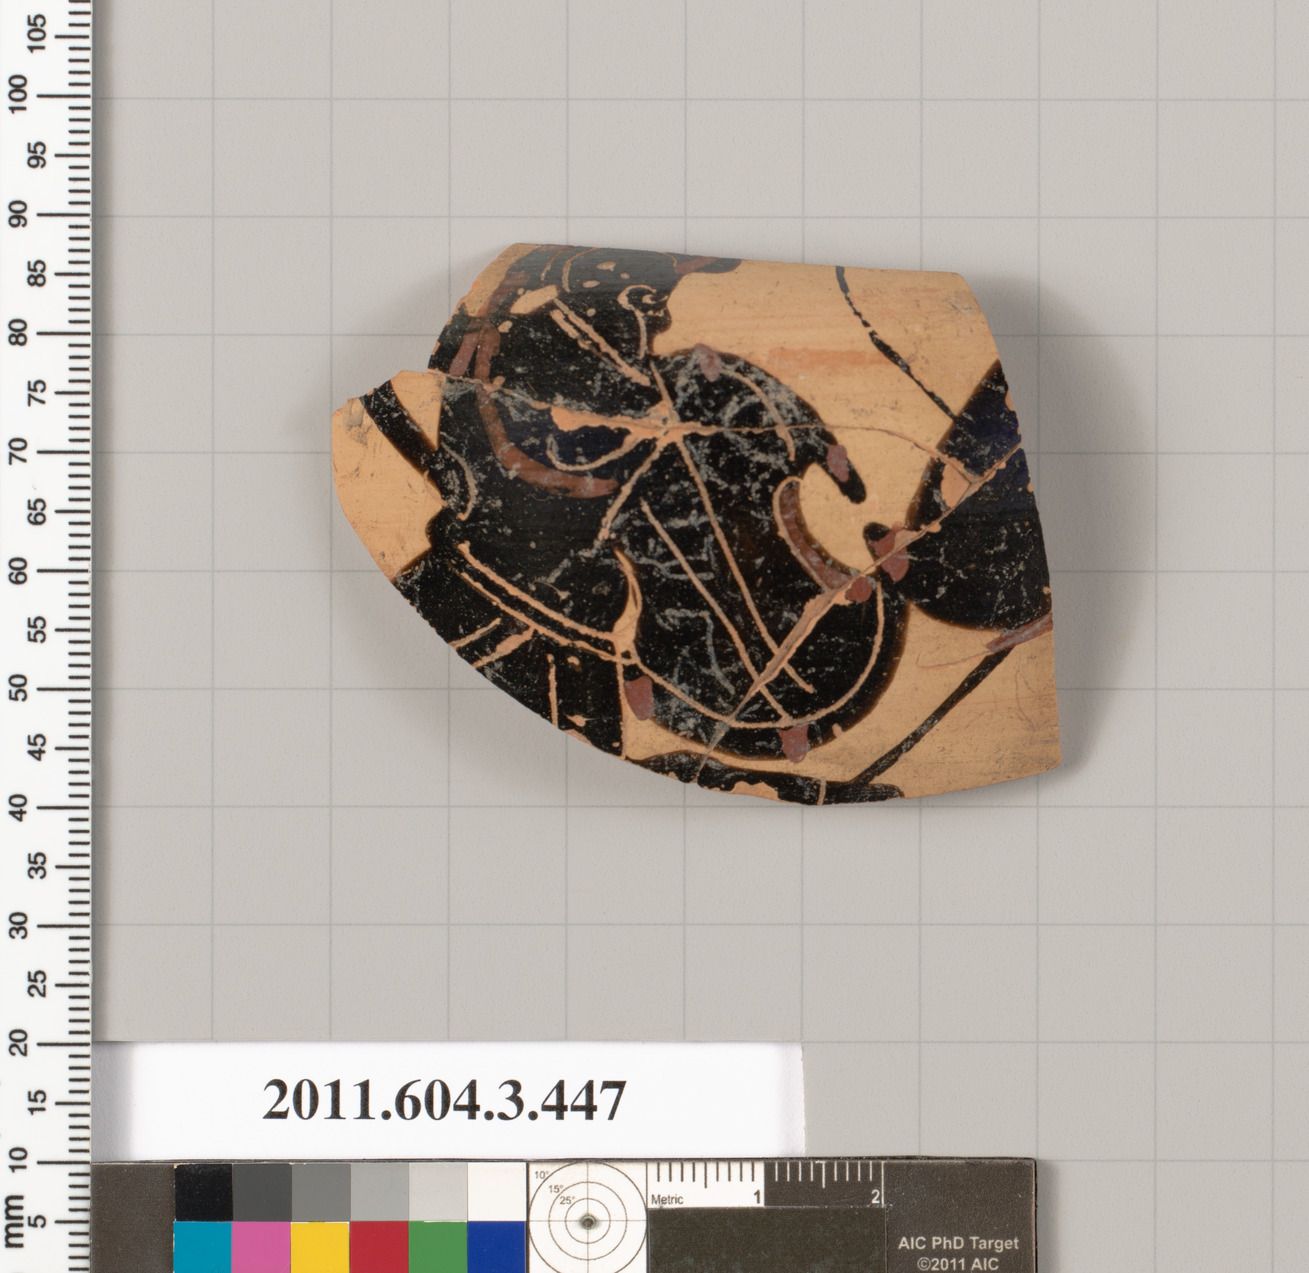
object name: neck amphora fragment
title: Terracotta fragment of a neck-amphora (jar)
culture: greek, attic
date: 490-480 BCE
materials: terracotta